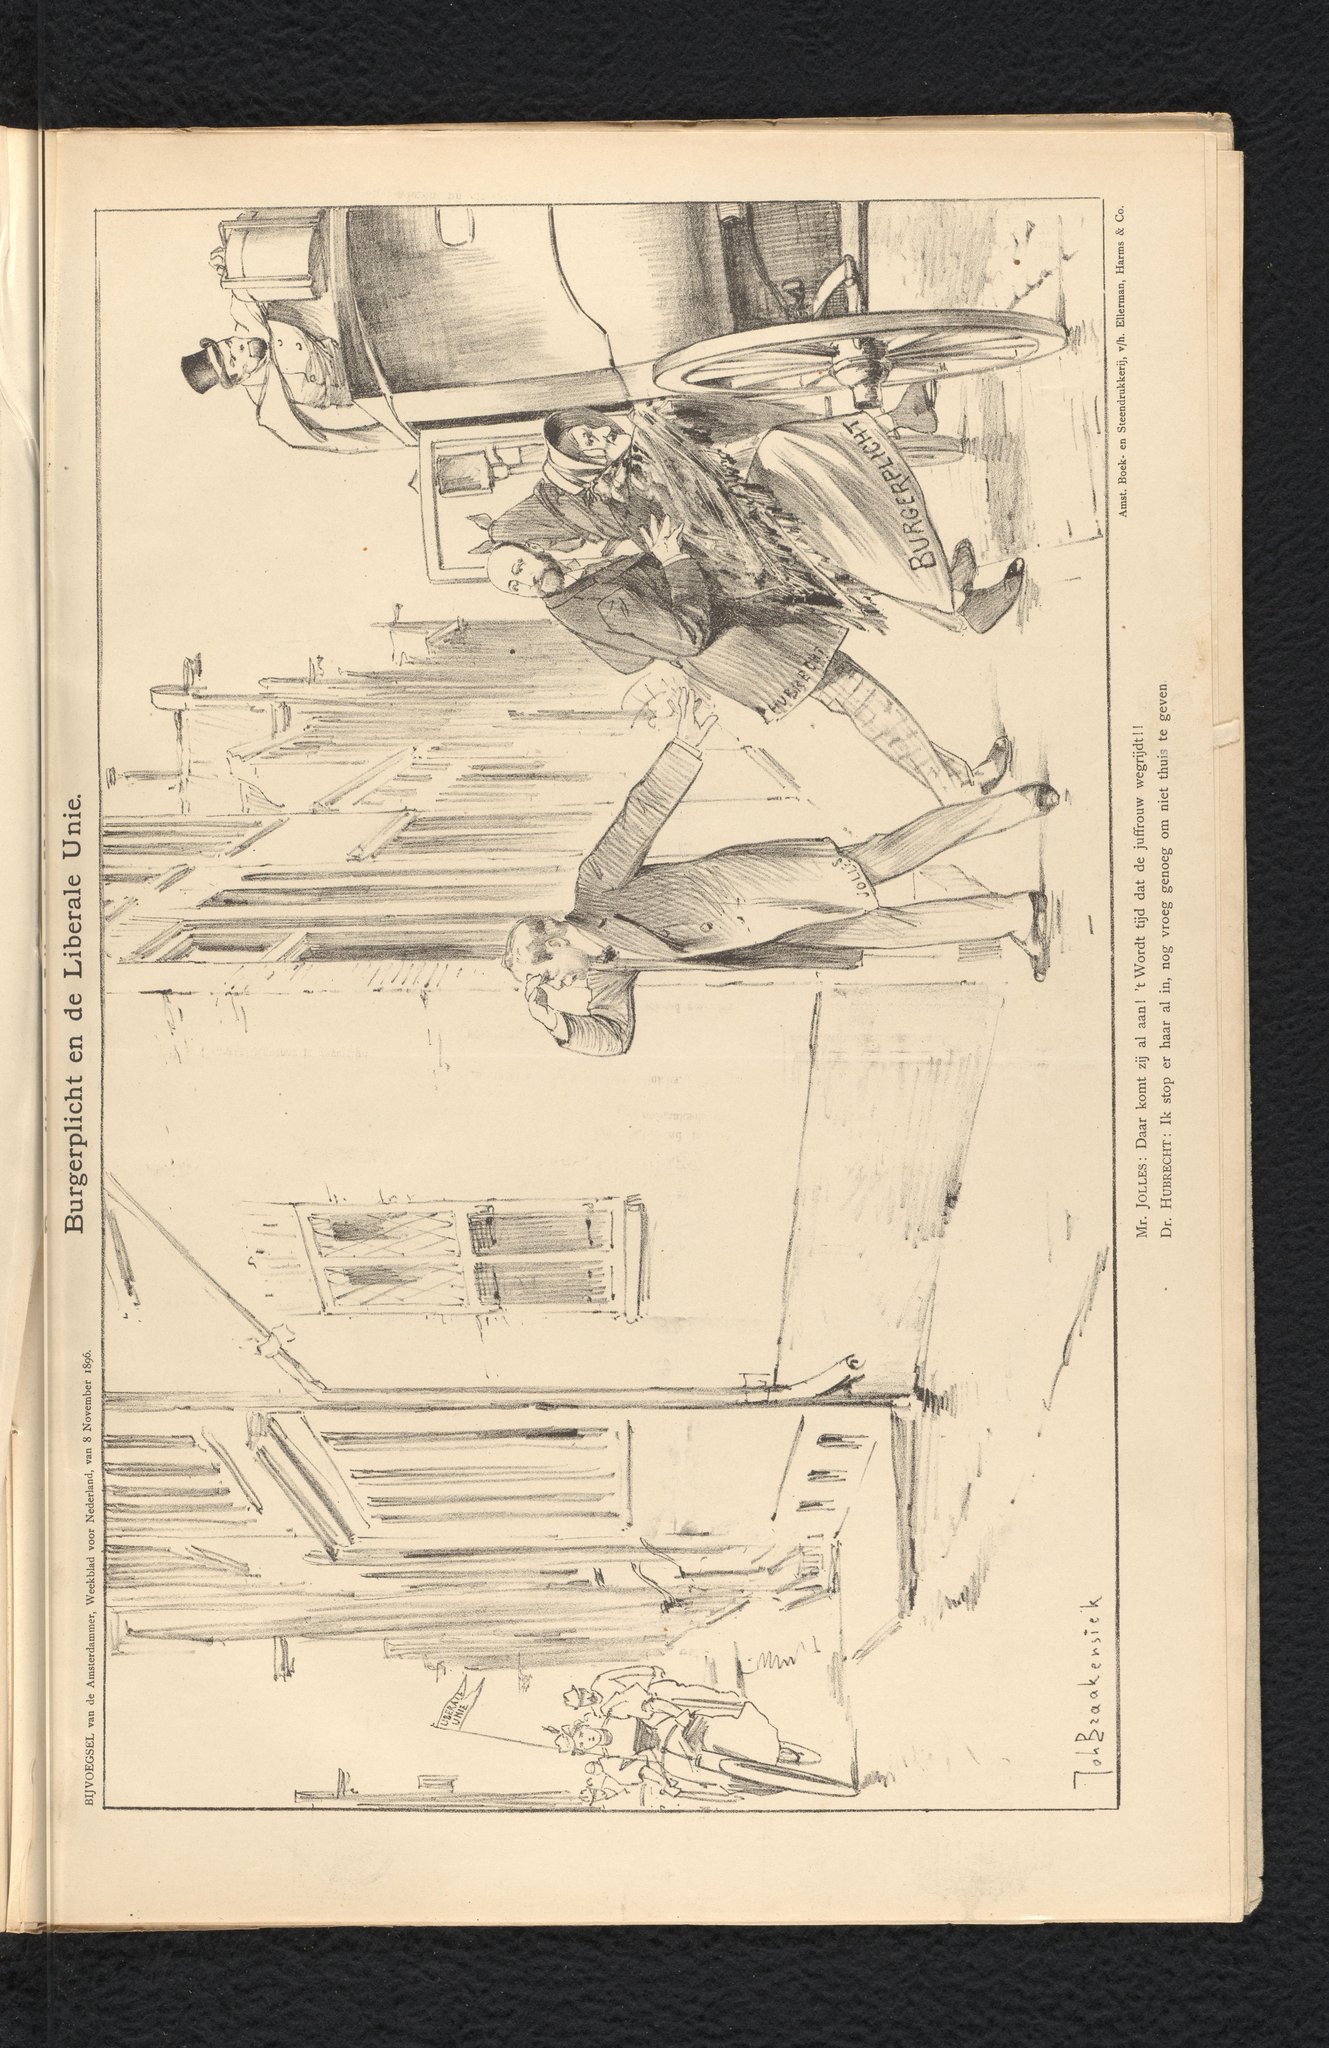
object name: cartoon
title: Burgerplicht en de Liberale Unie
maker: johan braakensiek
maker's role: draughtsman, print maker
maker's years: 1858-1940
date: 1896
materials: paper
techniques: lithograph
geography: amsterdam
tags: amsterdam, animal traction, animal-drawn vehicle (carriage etc.), bicycle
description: Adrianus Jolles en H.F.R. Hubrecht stoppen een oude vrouw 'Burgerplicht' in een wachtende koets terwijl een jonge vrouw 'Liberale Unie' vanuit de andere kant komt aanfietsen.